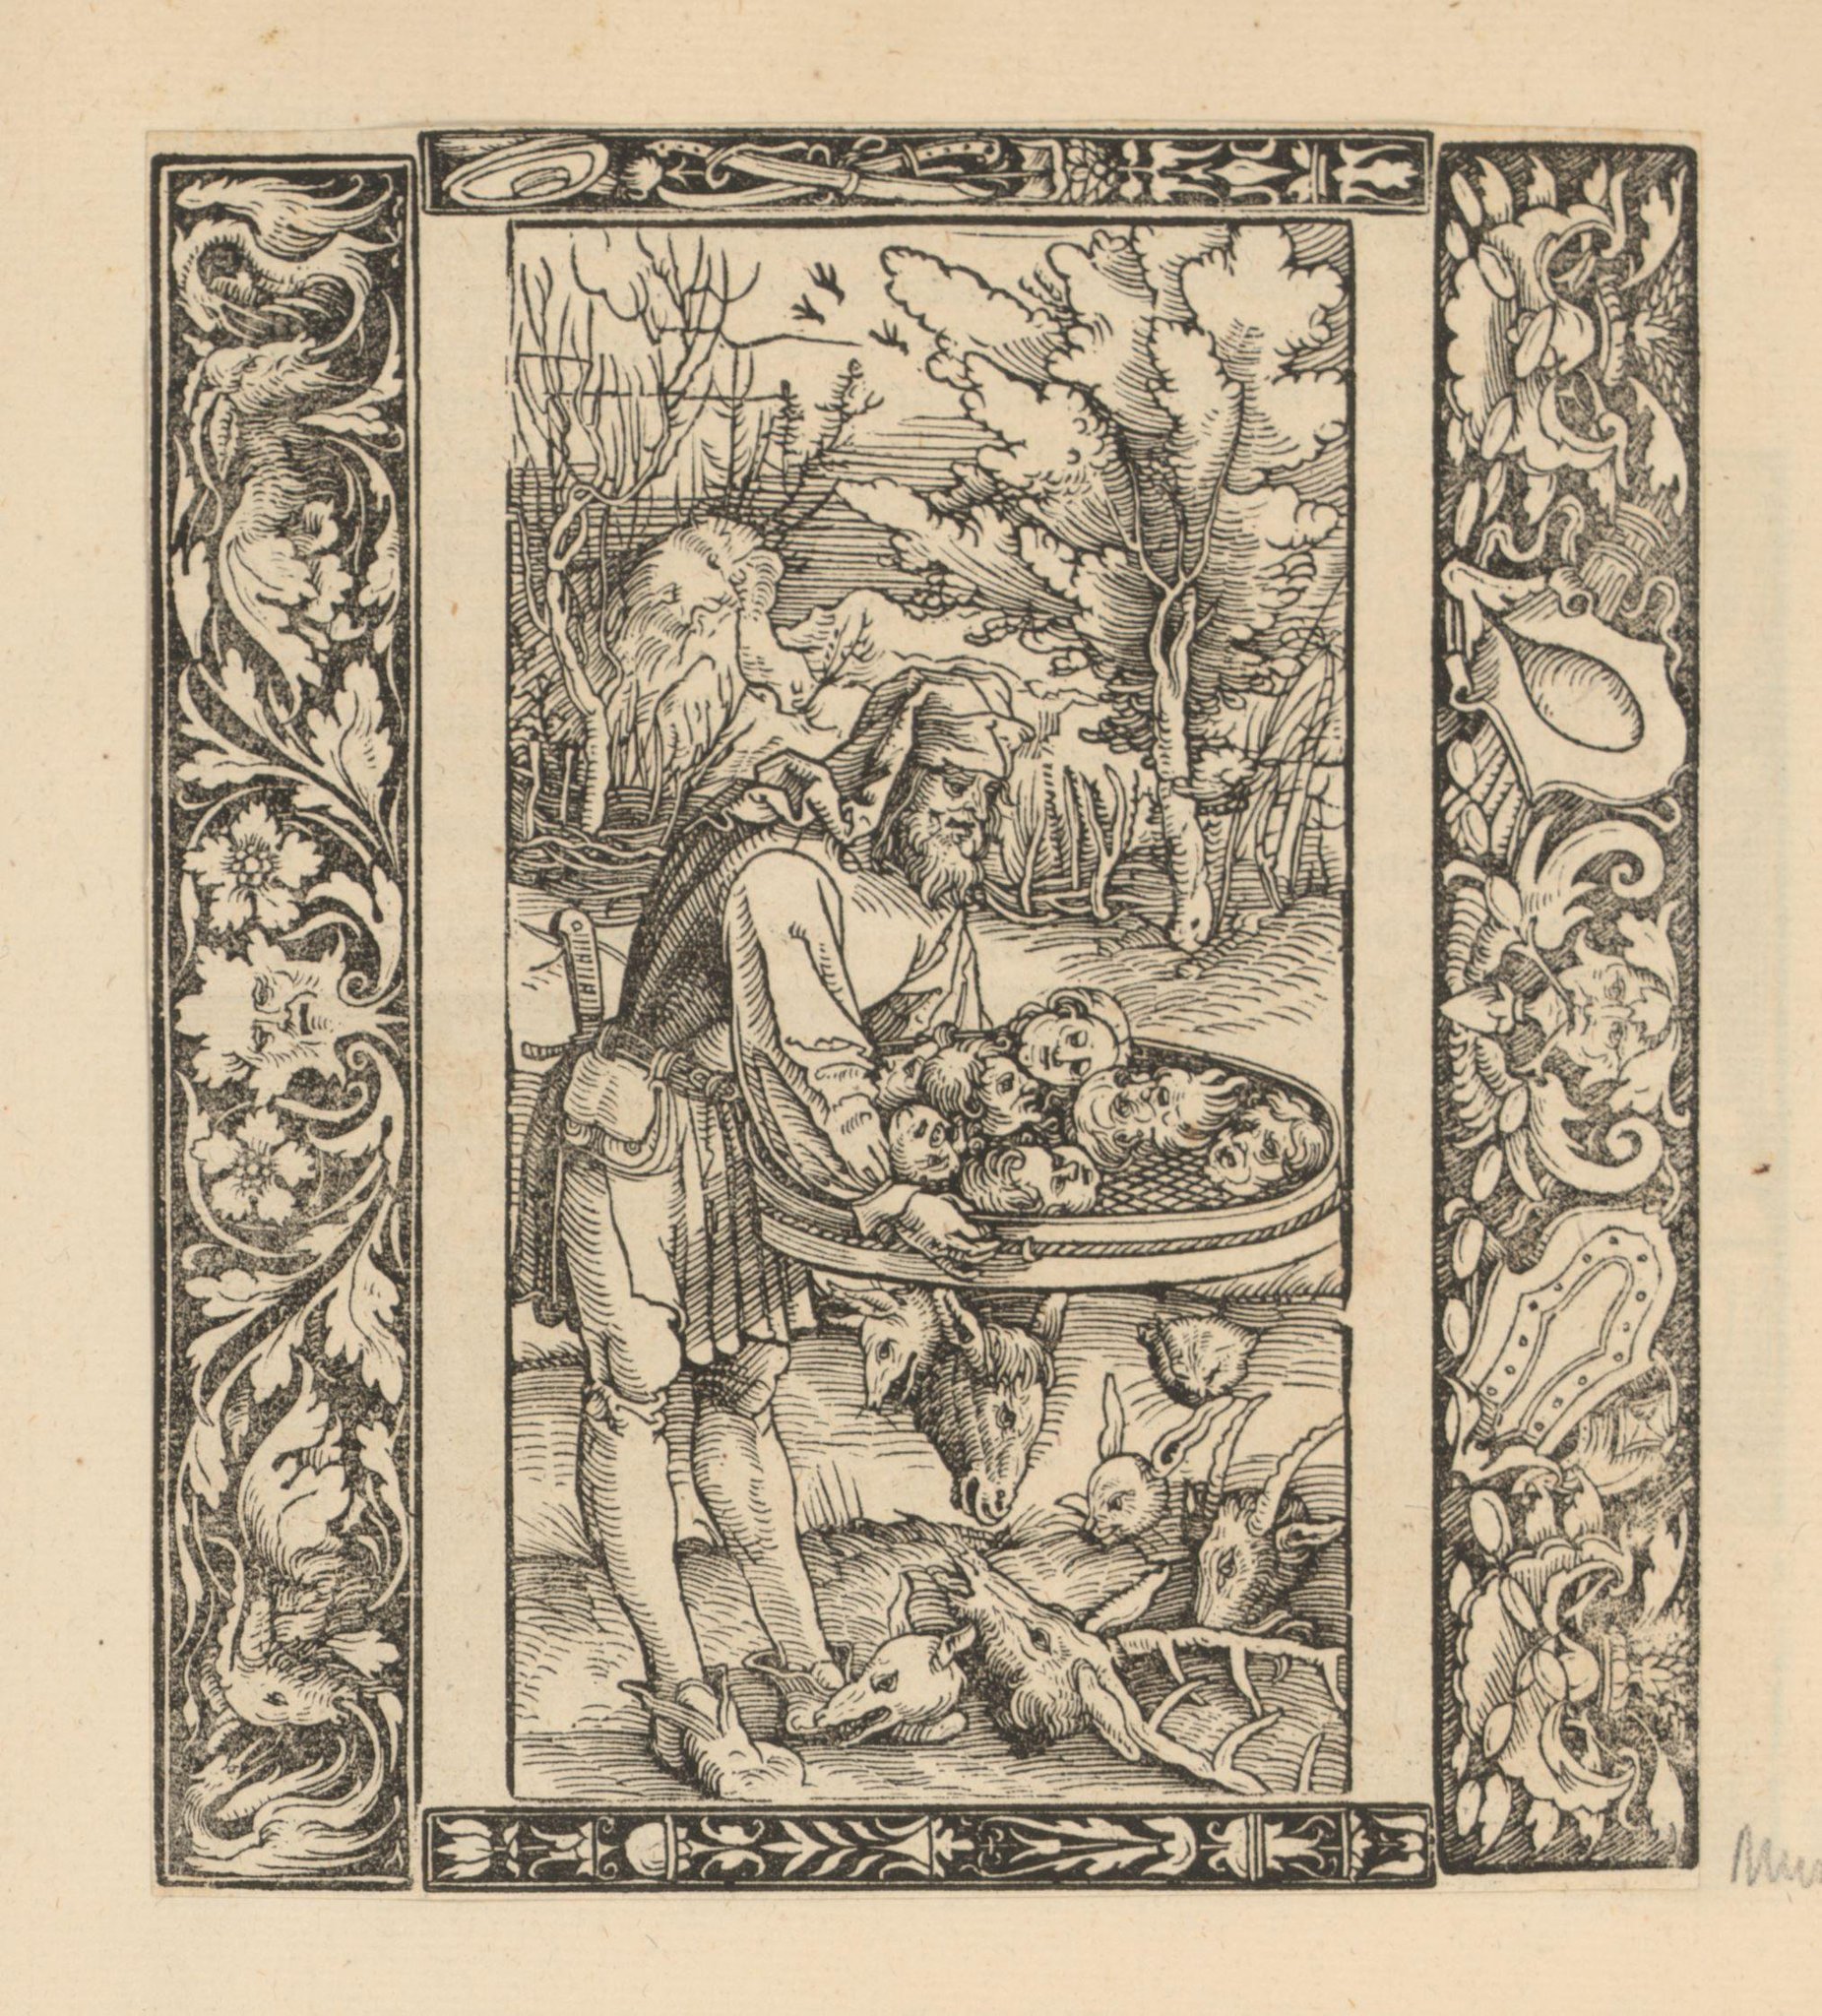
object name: book illustration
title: Landschap met een man die een mand vol mensenhoofden en dierenkoppen vasthoudt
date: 1514-1531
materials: paper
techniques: letterpress printing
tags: ornament ~ candelabrum, head of a beheaded person on a plate, hunting accoutrement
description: Deze prent is gebruikt in: Cicero, Marcus Tulius. Officia M.T.C. Ein Buch so Marcus Tullius Cicero der Römer zu seynem (...). [Vertaald uit het Latijn door] Johann von Schwarzenberg. Augsburg: Heinrich Steiner, 1531.